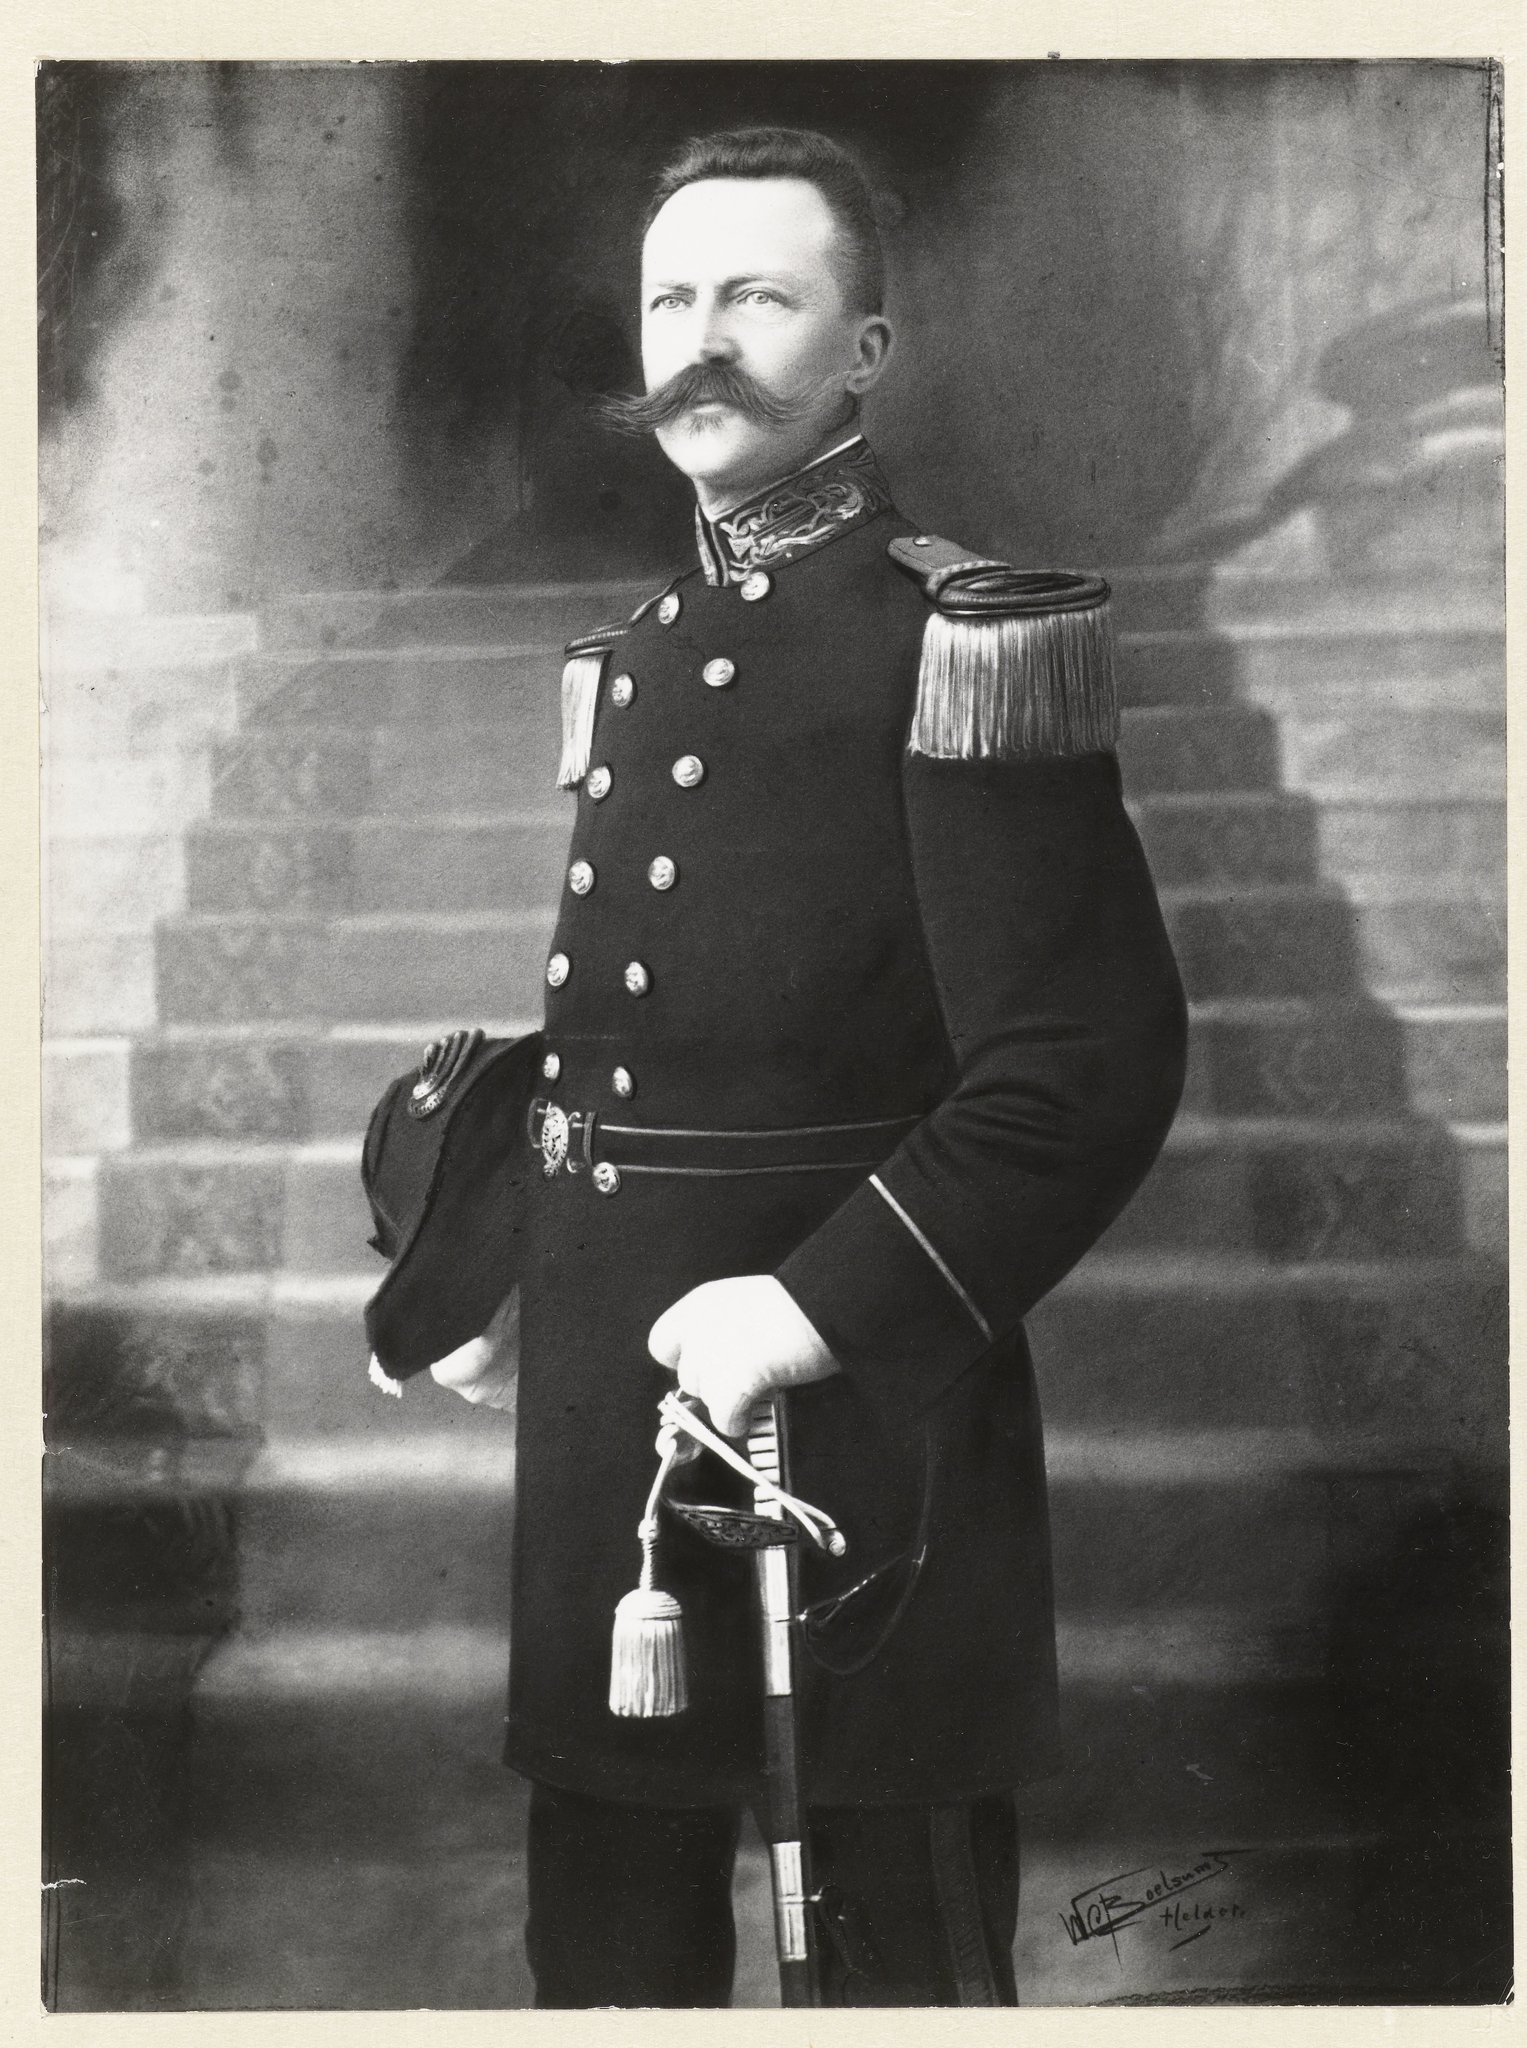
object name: photograph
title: Hazenbroek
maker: willem frederik boelsums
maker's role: fotograaf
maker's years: 1851-1907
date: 1920-1985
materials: paper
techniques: gelatin silver print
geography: den helder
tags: historical persons (portraits and scenes from the life), netherlands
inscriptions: signature: ‘W.F. Boelsums’